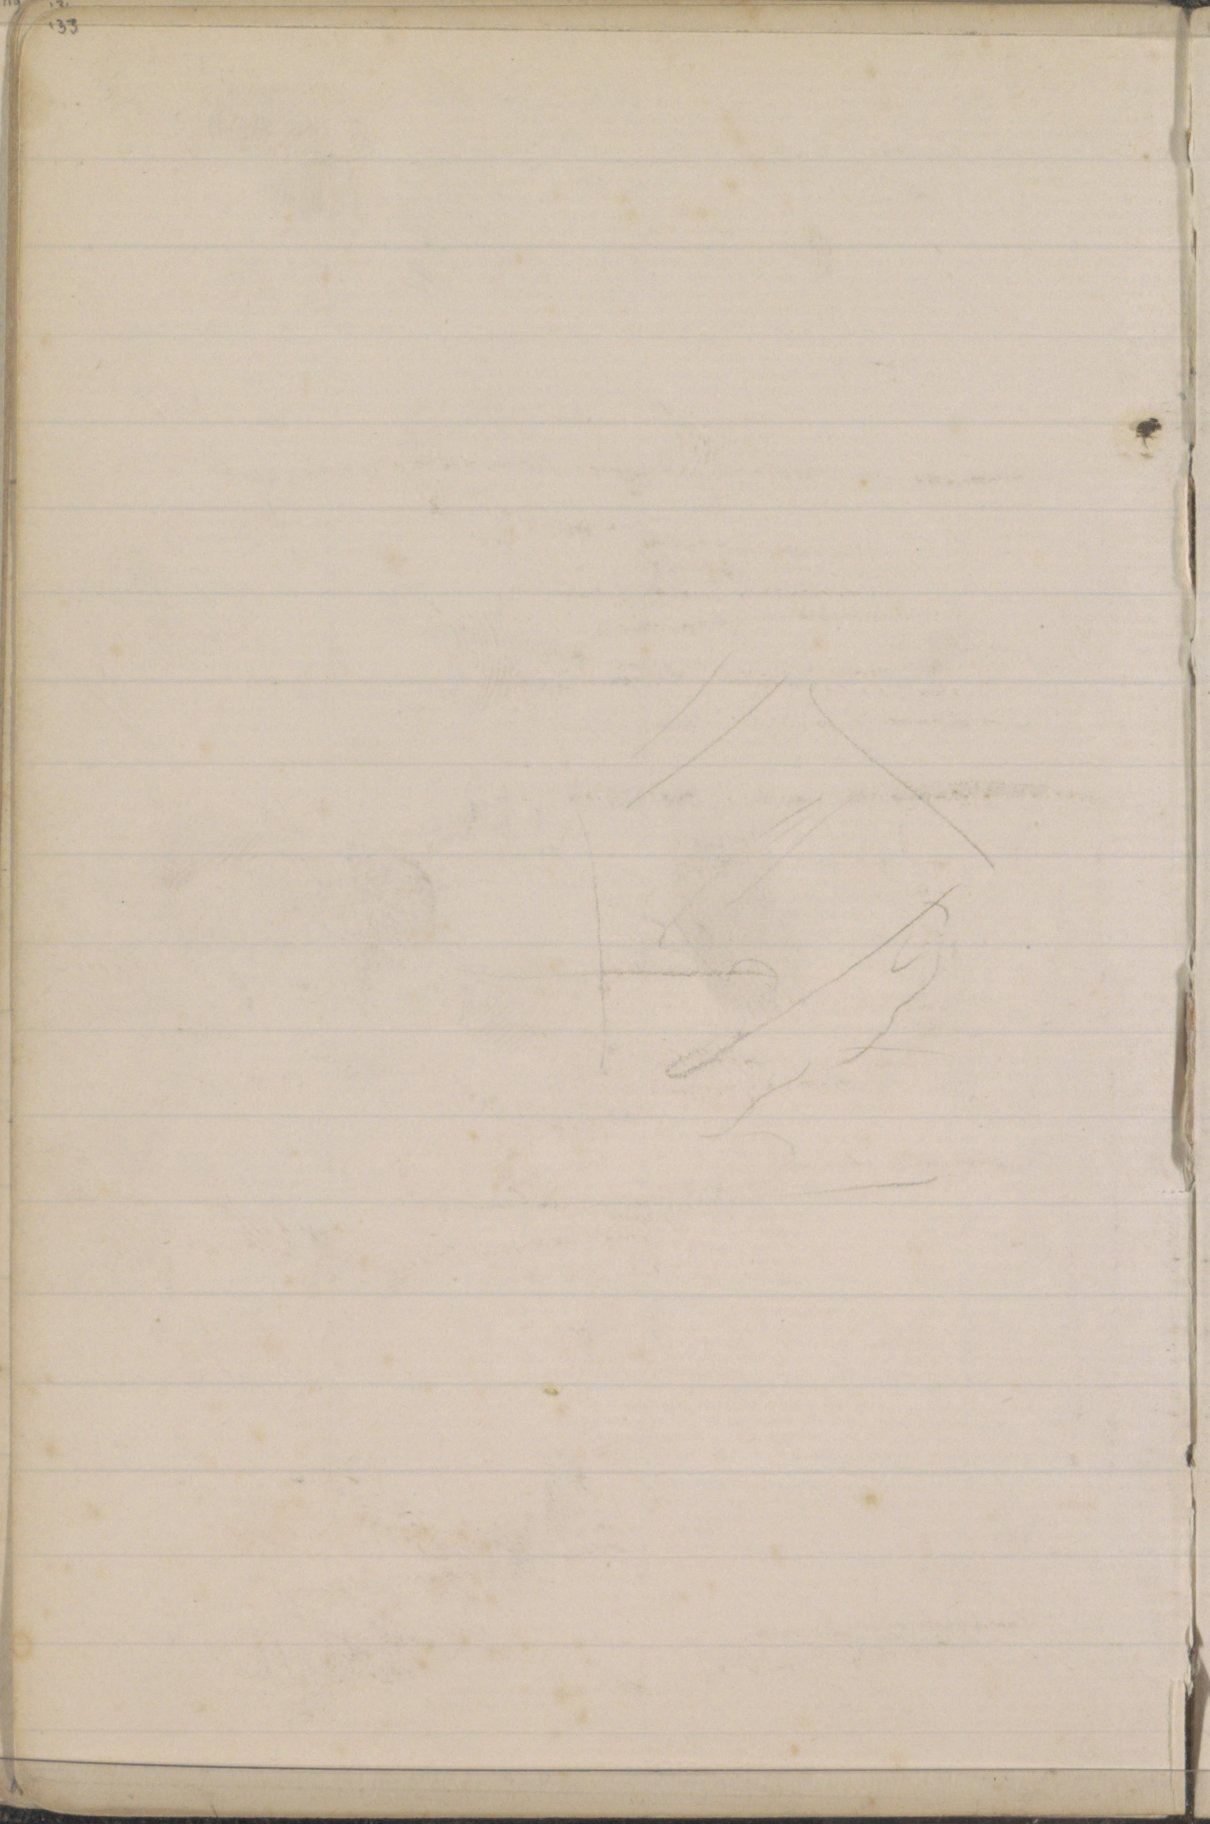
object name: sketchbook leaf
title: Studie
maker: marius bauer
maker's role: draughtsman, print maker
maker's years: 1867-1932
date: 1897-1898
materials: pencil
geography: india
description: Pagina 133 uit een schetsboek met 84 bladen.